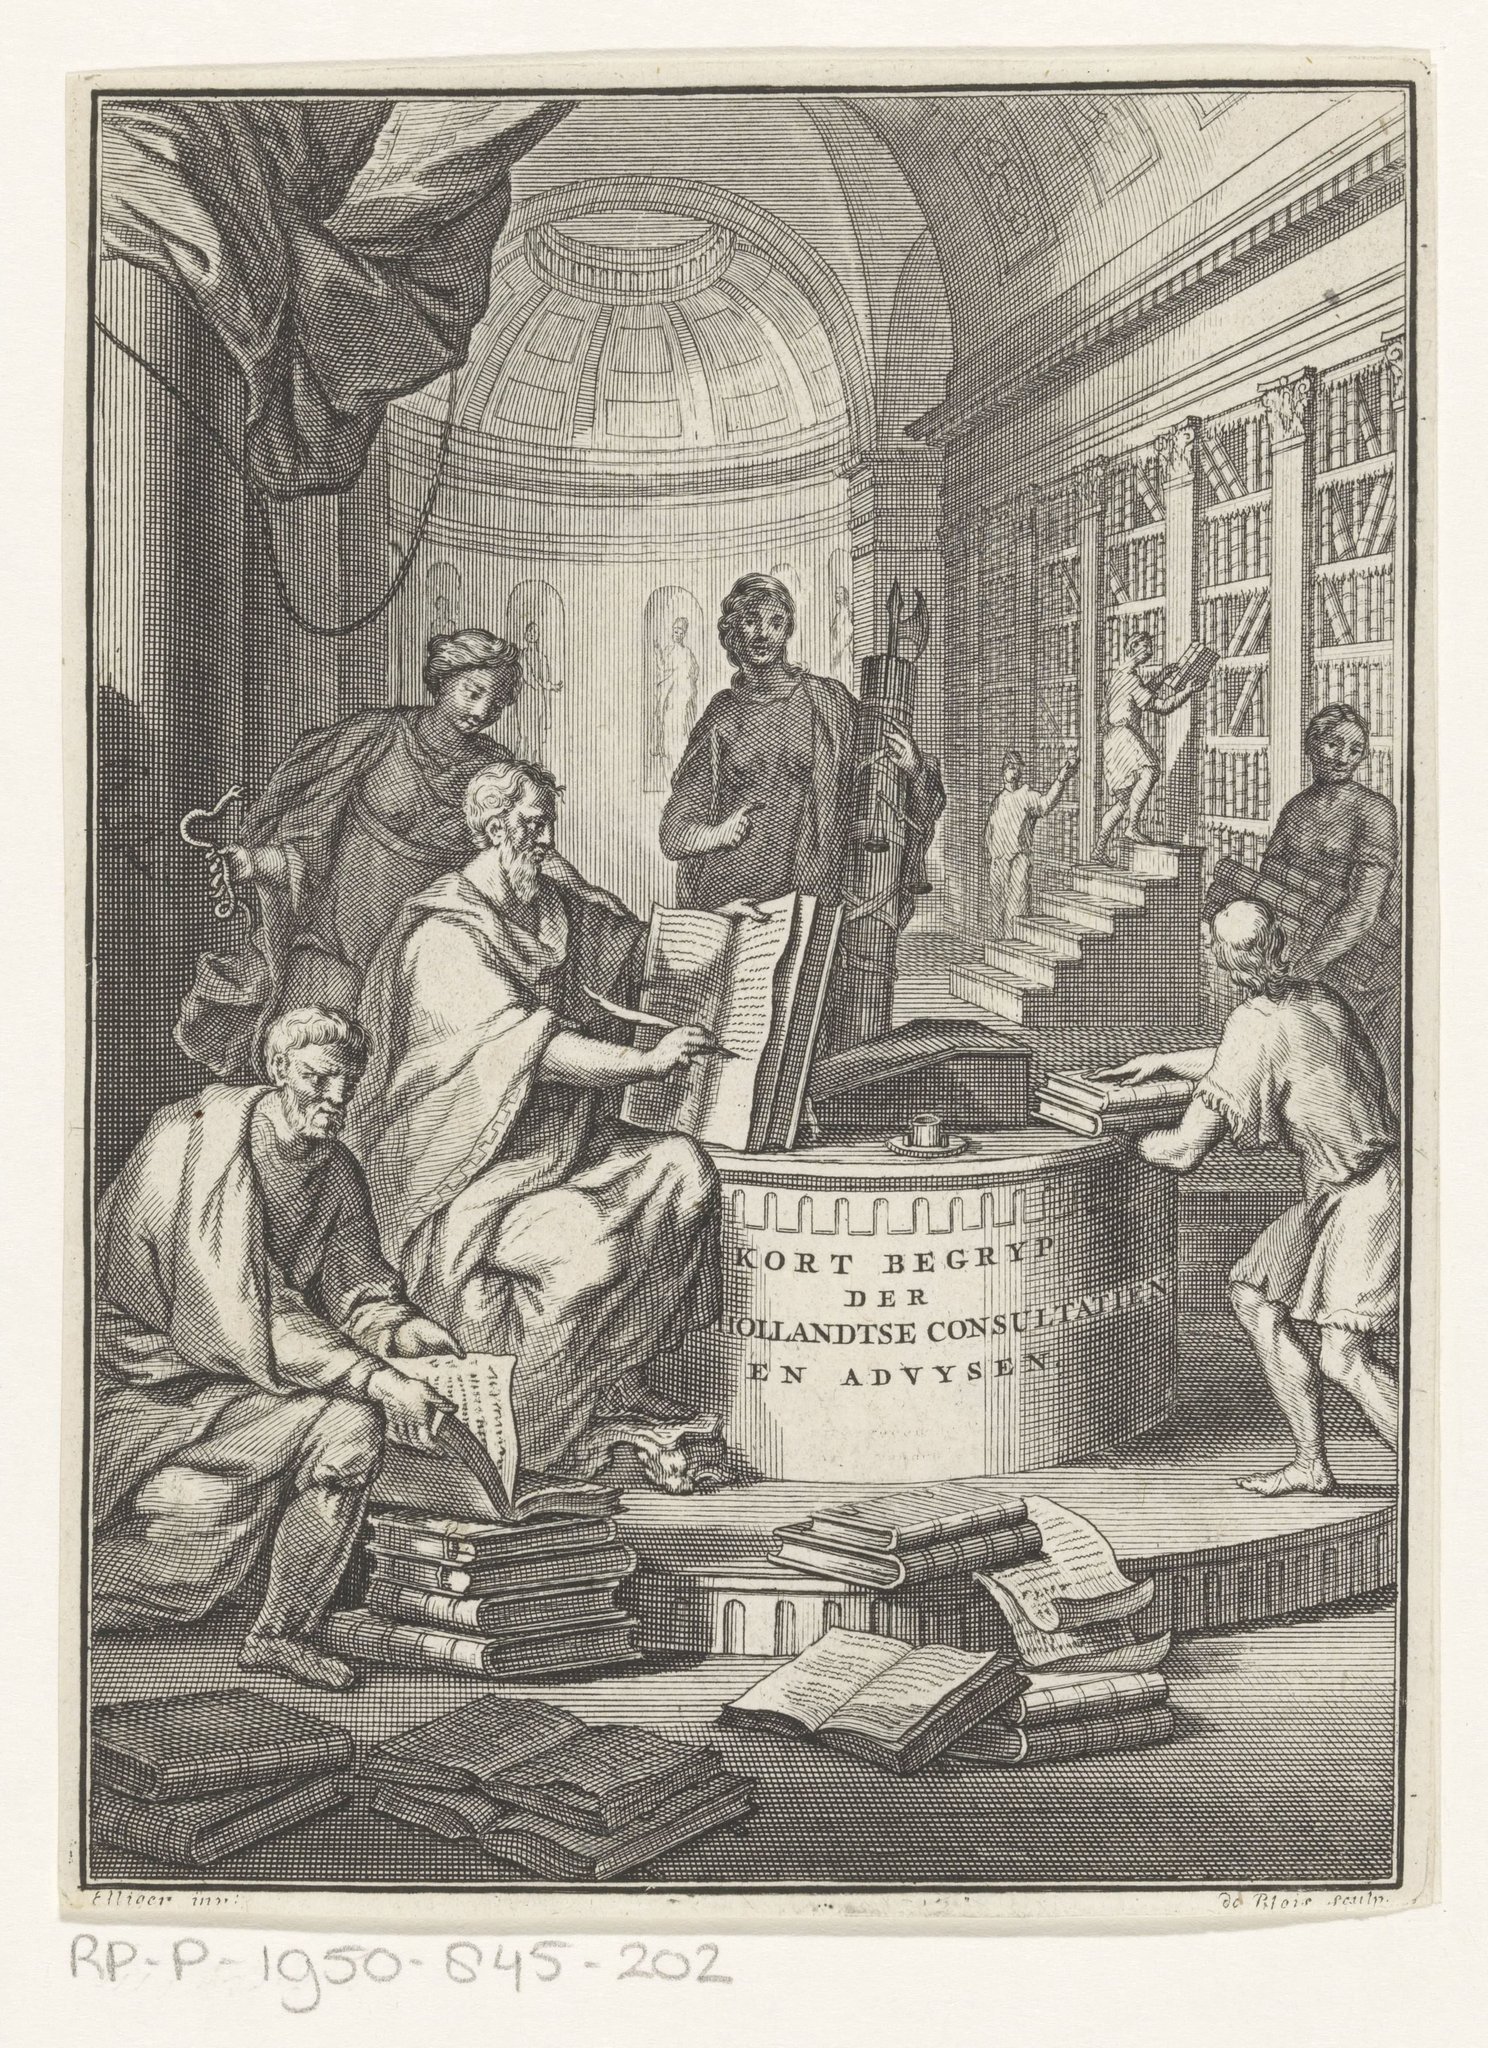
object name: print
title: Titelpagina voor: S.n., Kort begryp van de ses deelen der Hollandse consultatien en advysen, inhoudende alle de voortreffelyke materien en voorvallen, daar in begrepen, 1709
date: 1696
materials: paper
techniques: engraving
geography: amsterdam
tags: justice, 'justitia'; 'giustitia divina' (ripa) ~ one of the four cardinal virtues, public library, civil law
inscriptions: collector's mark: Lugt 2228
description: Titelpagina voor: S.n. Kort begryp van de ses deelen der Hollandse consultatien en advysen, inhoudende alle de voortreffelyke materien en voorvallen, daar in begrepen, Amsterdam: Someren, Abraham van, 1696. Prent is afkomstig uit een plakalbum met titelprenten, ornamenten etc. op blauw papier dat in 1983 uit elkaar is gehaald. Volgens een notitie op verso zat de prent op p. 202 van dit album.